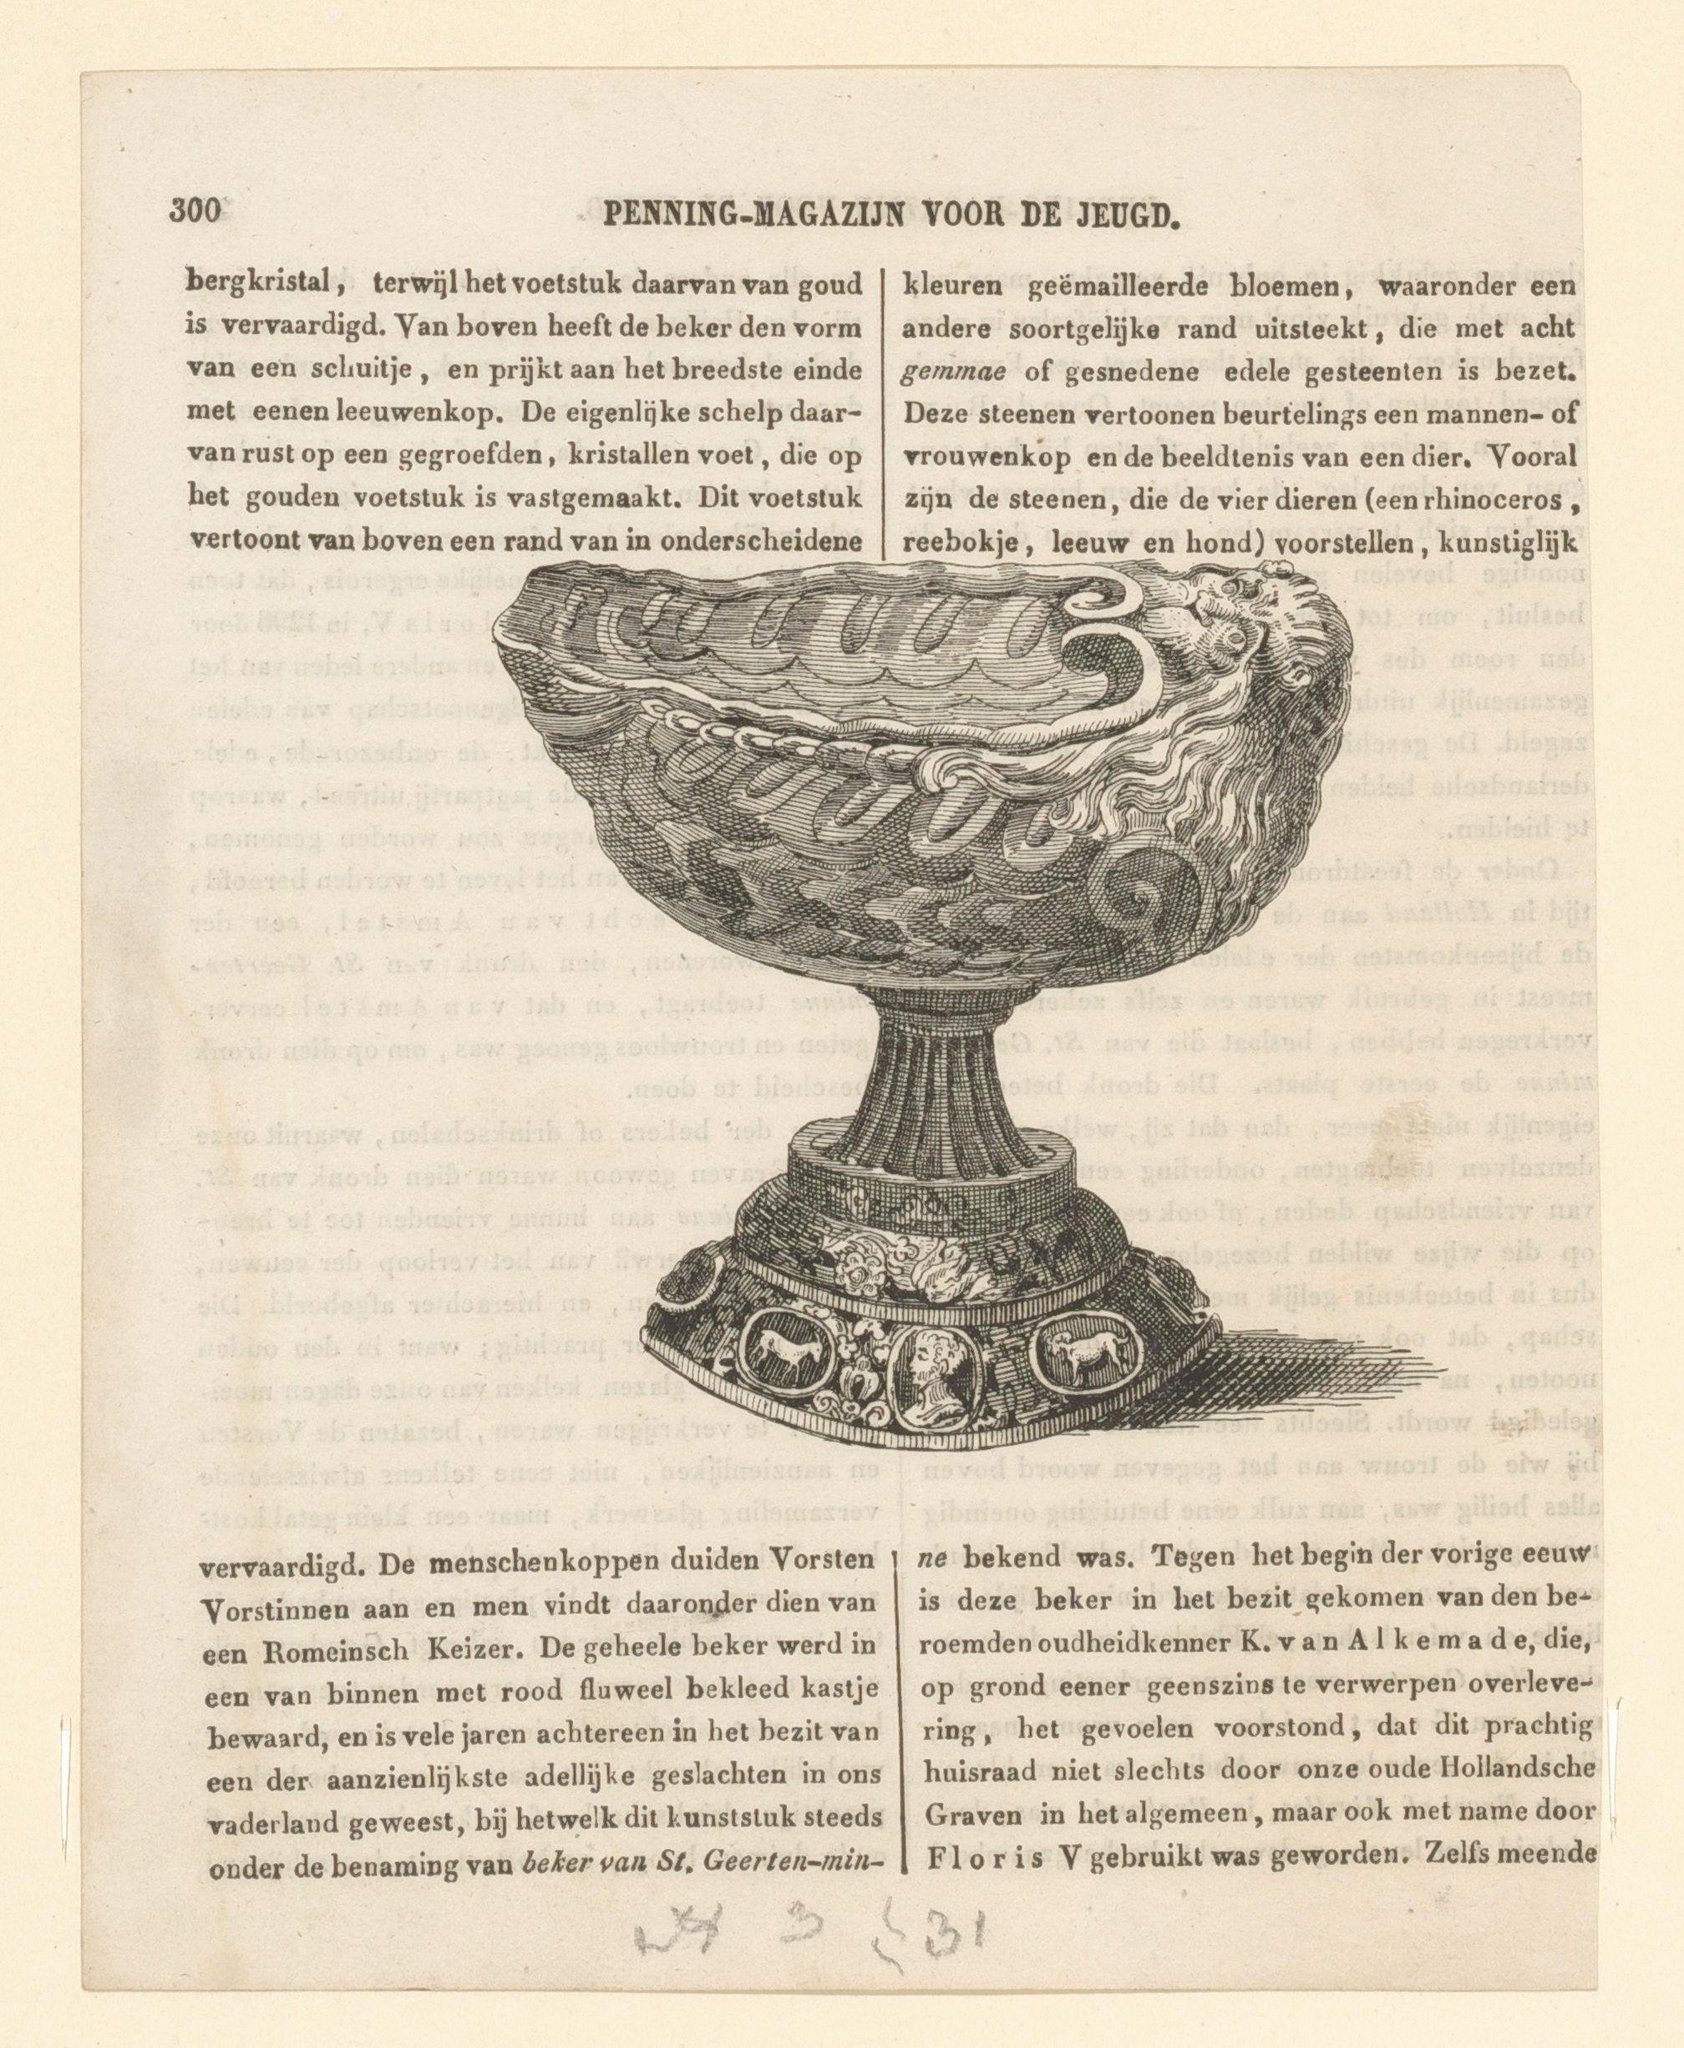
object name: print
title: St. Geerte Minne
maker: Anonymous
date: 1850-1899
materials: paper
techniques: engraving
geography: netherlands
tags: glass, rummer, alcoholic drinks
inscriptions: collector's mark: Lugt 1641, collector's mark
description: Gebruikt als illustratie in: Penning-Magazijn voor de Jeugd, p. 299-300 (datum onbekend). Kopie naar de illustratie in: Cornelis van Alkemade en Pieter van der Schelling, Nederlands displegtigheden. Rotterdam: Philippus Losel, 3 dln. 1732-1735, dl. II (1732), t.o. p. 481.